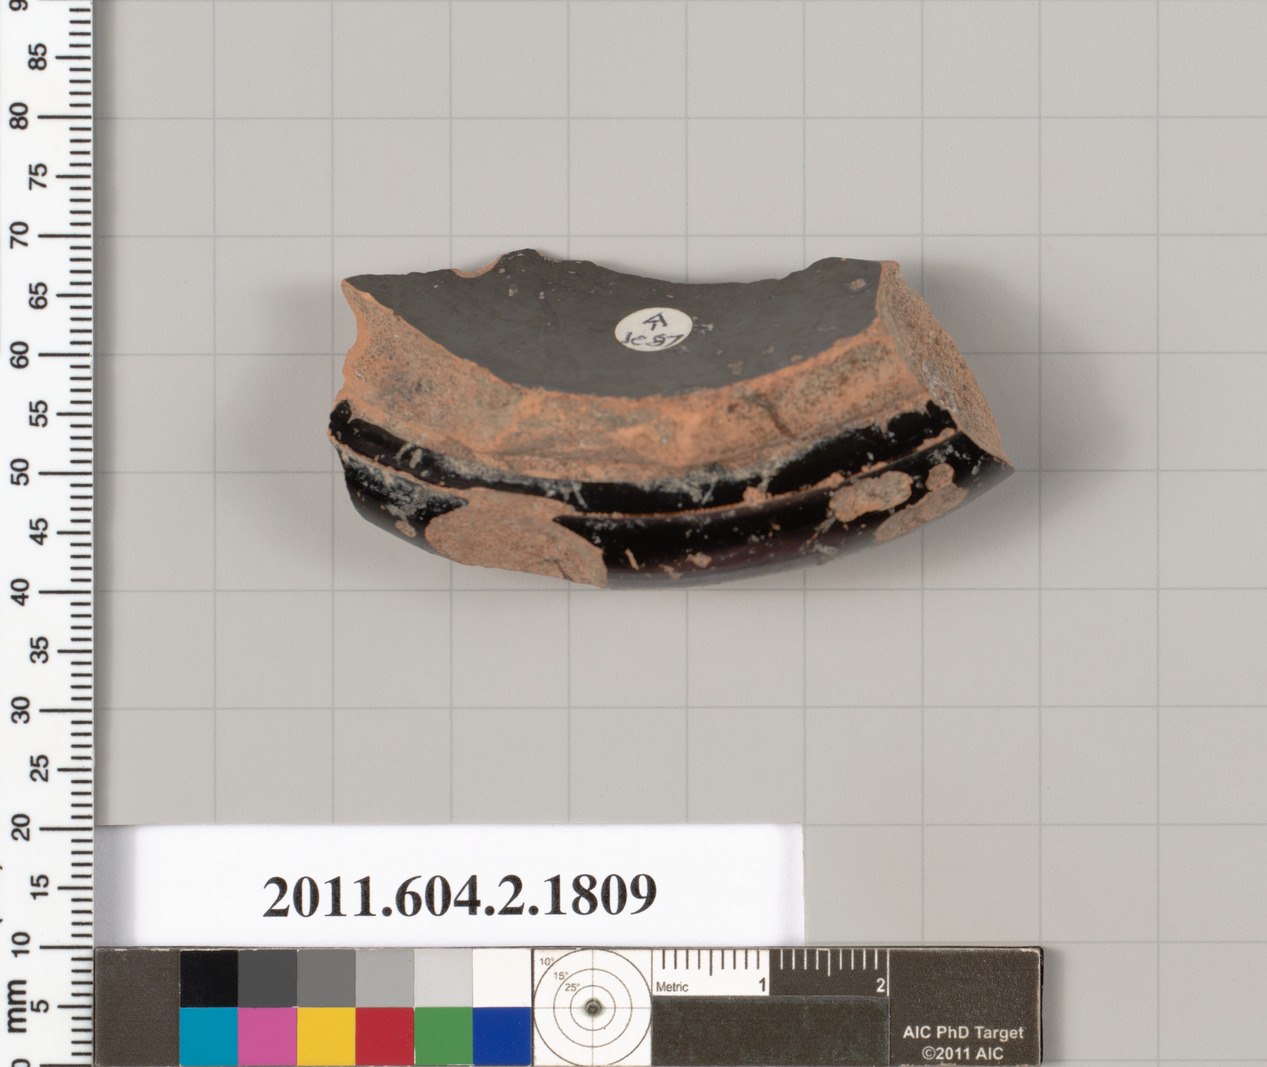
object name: skyphos fragment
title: Terracotta fragment of a skyphos (deep drinking cup)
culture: greek, attic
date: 500-401 BCE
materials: terracotta